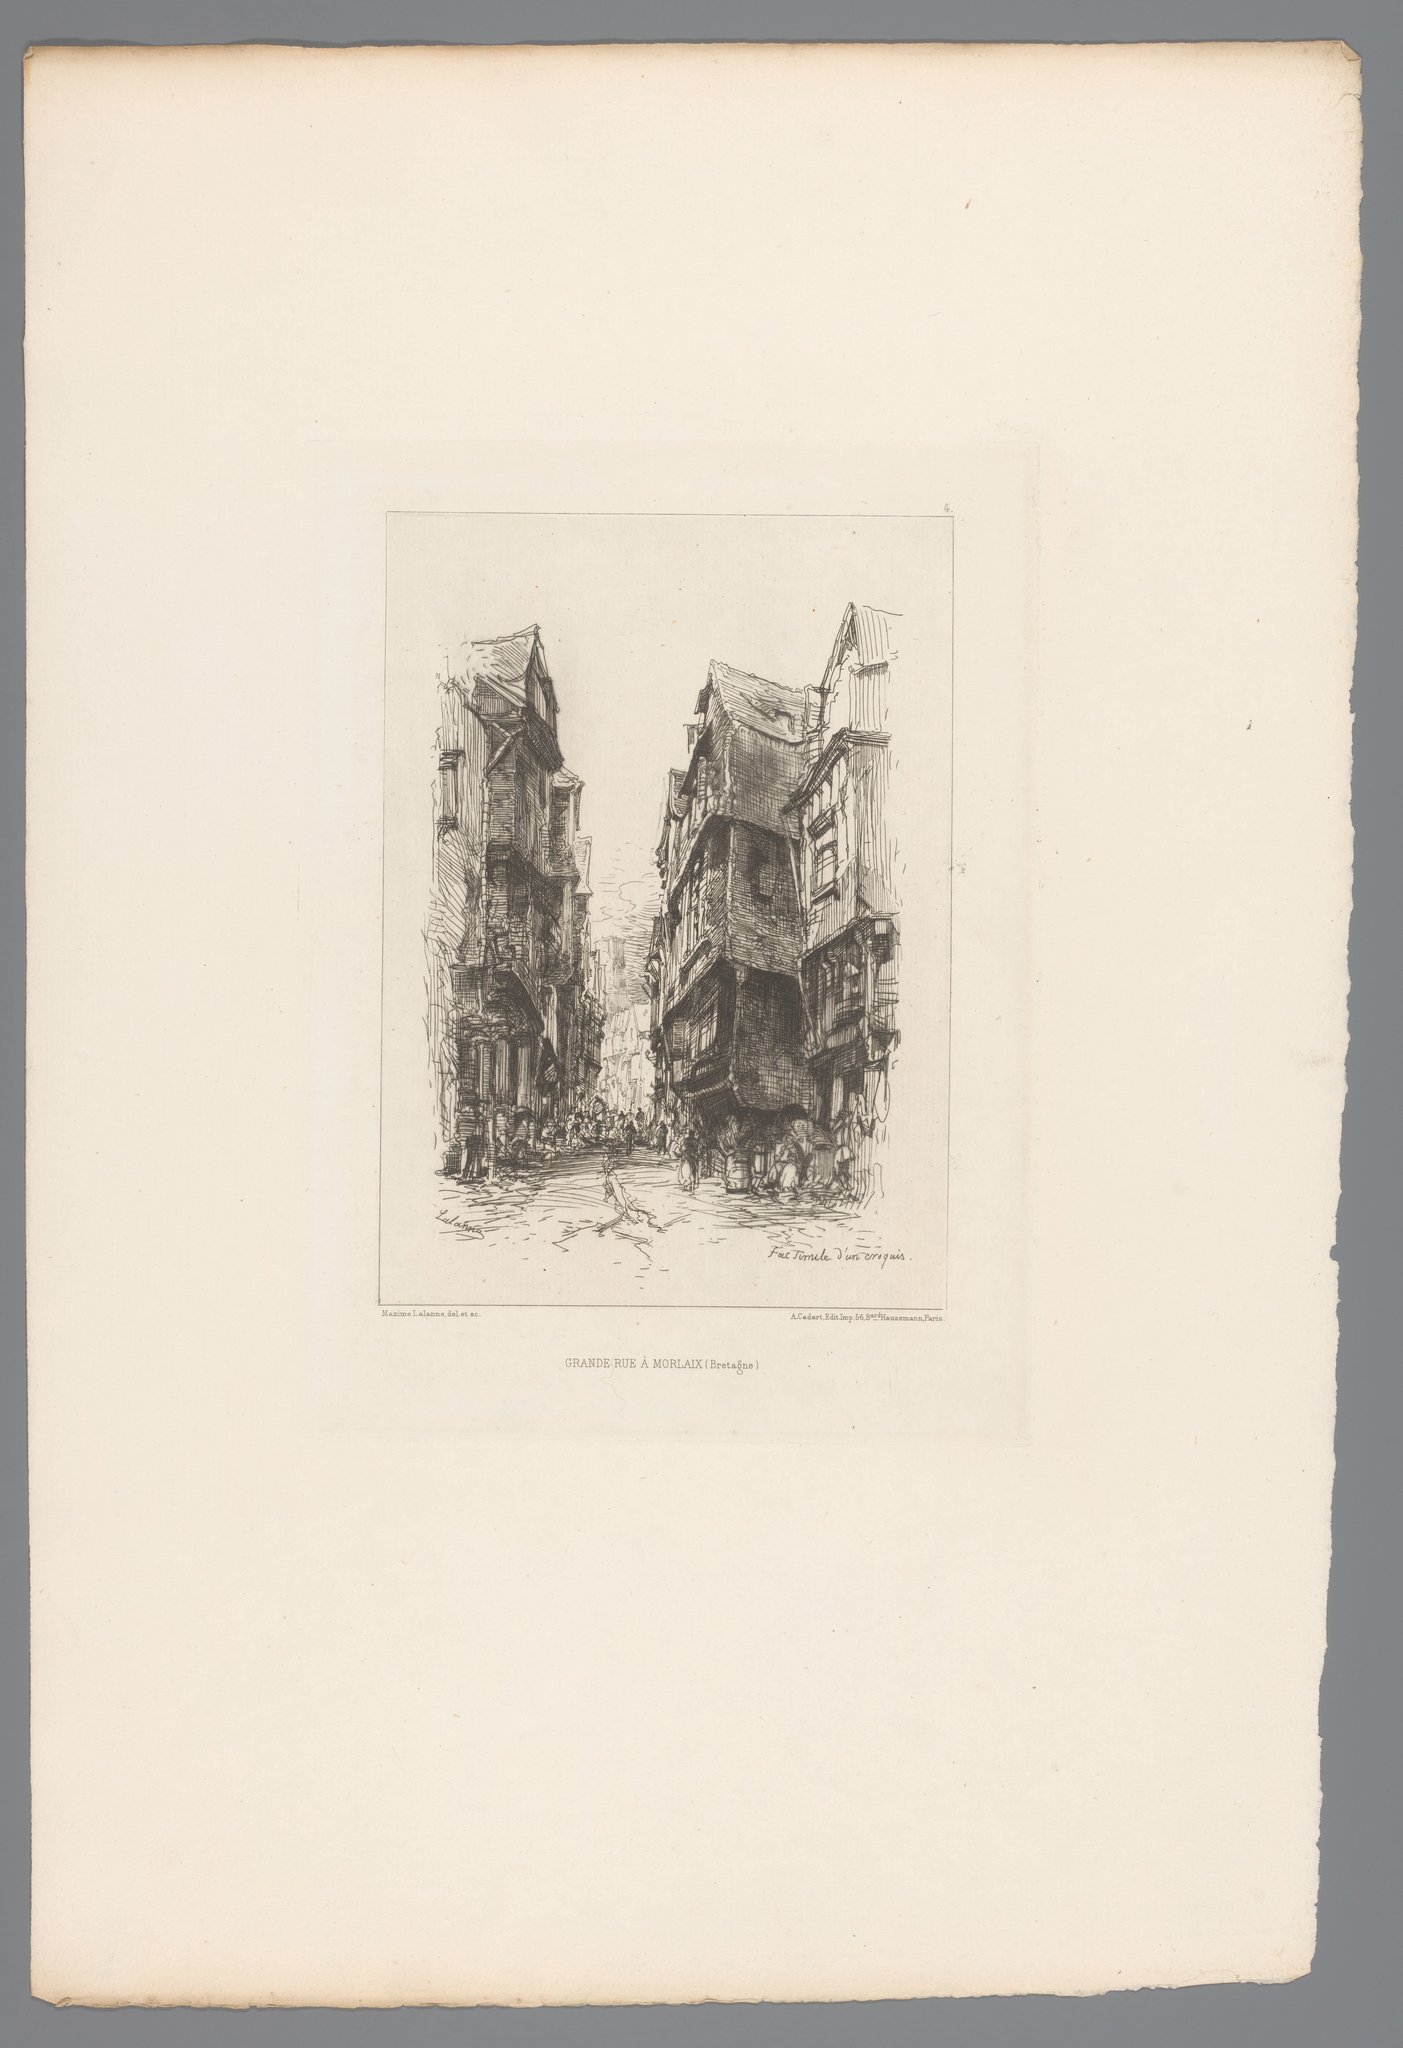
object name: print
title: L'eau-forte en 1875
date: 1875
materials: paper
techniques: drypoint, etching, intaglio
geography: paris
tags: street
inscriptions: collector's mark: Lugt 2228, collector's mark: Lugt 2760, collector's mark: ‘AFE v S’